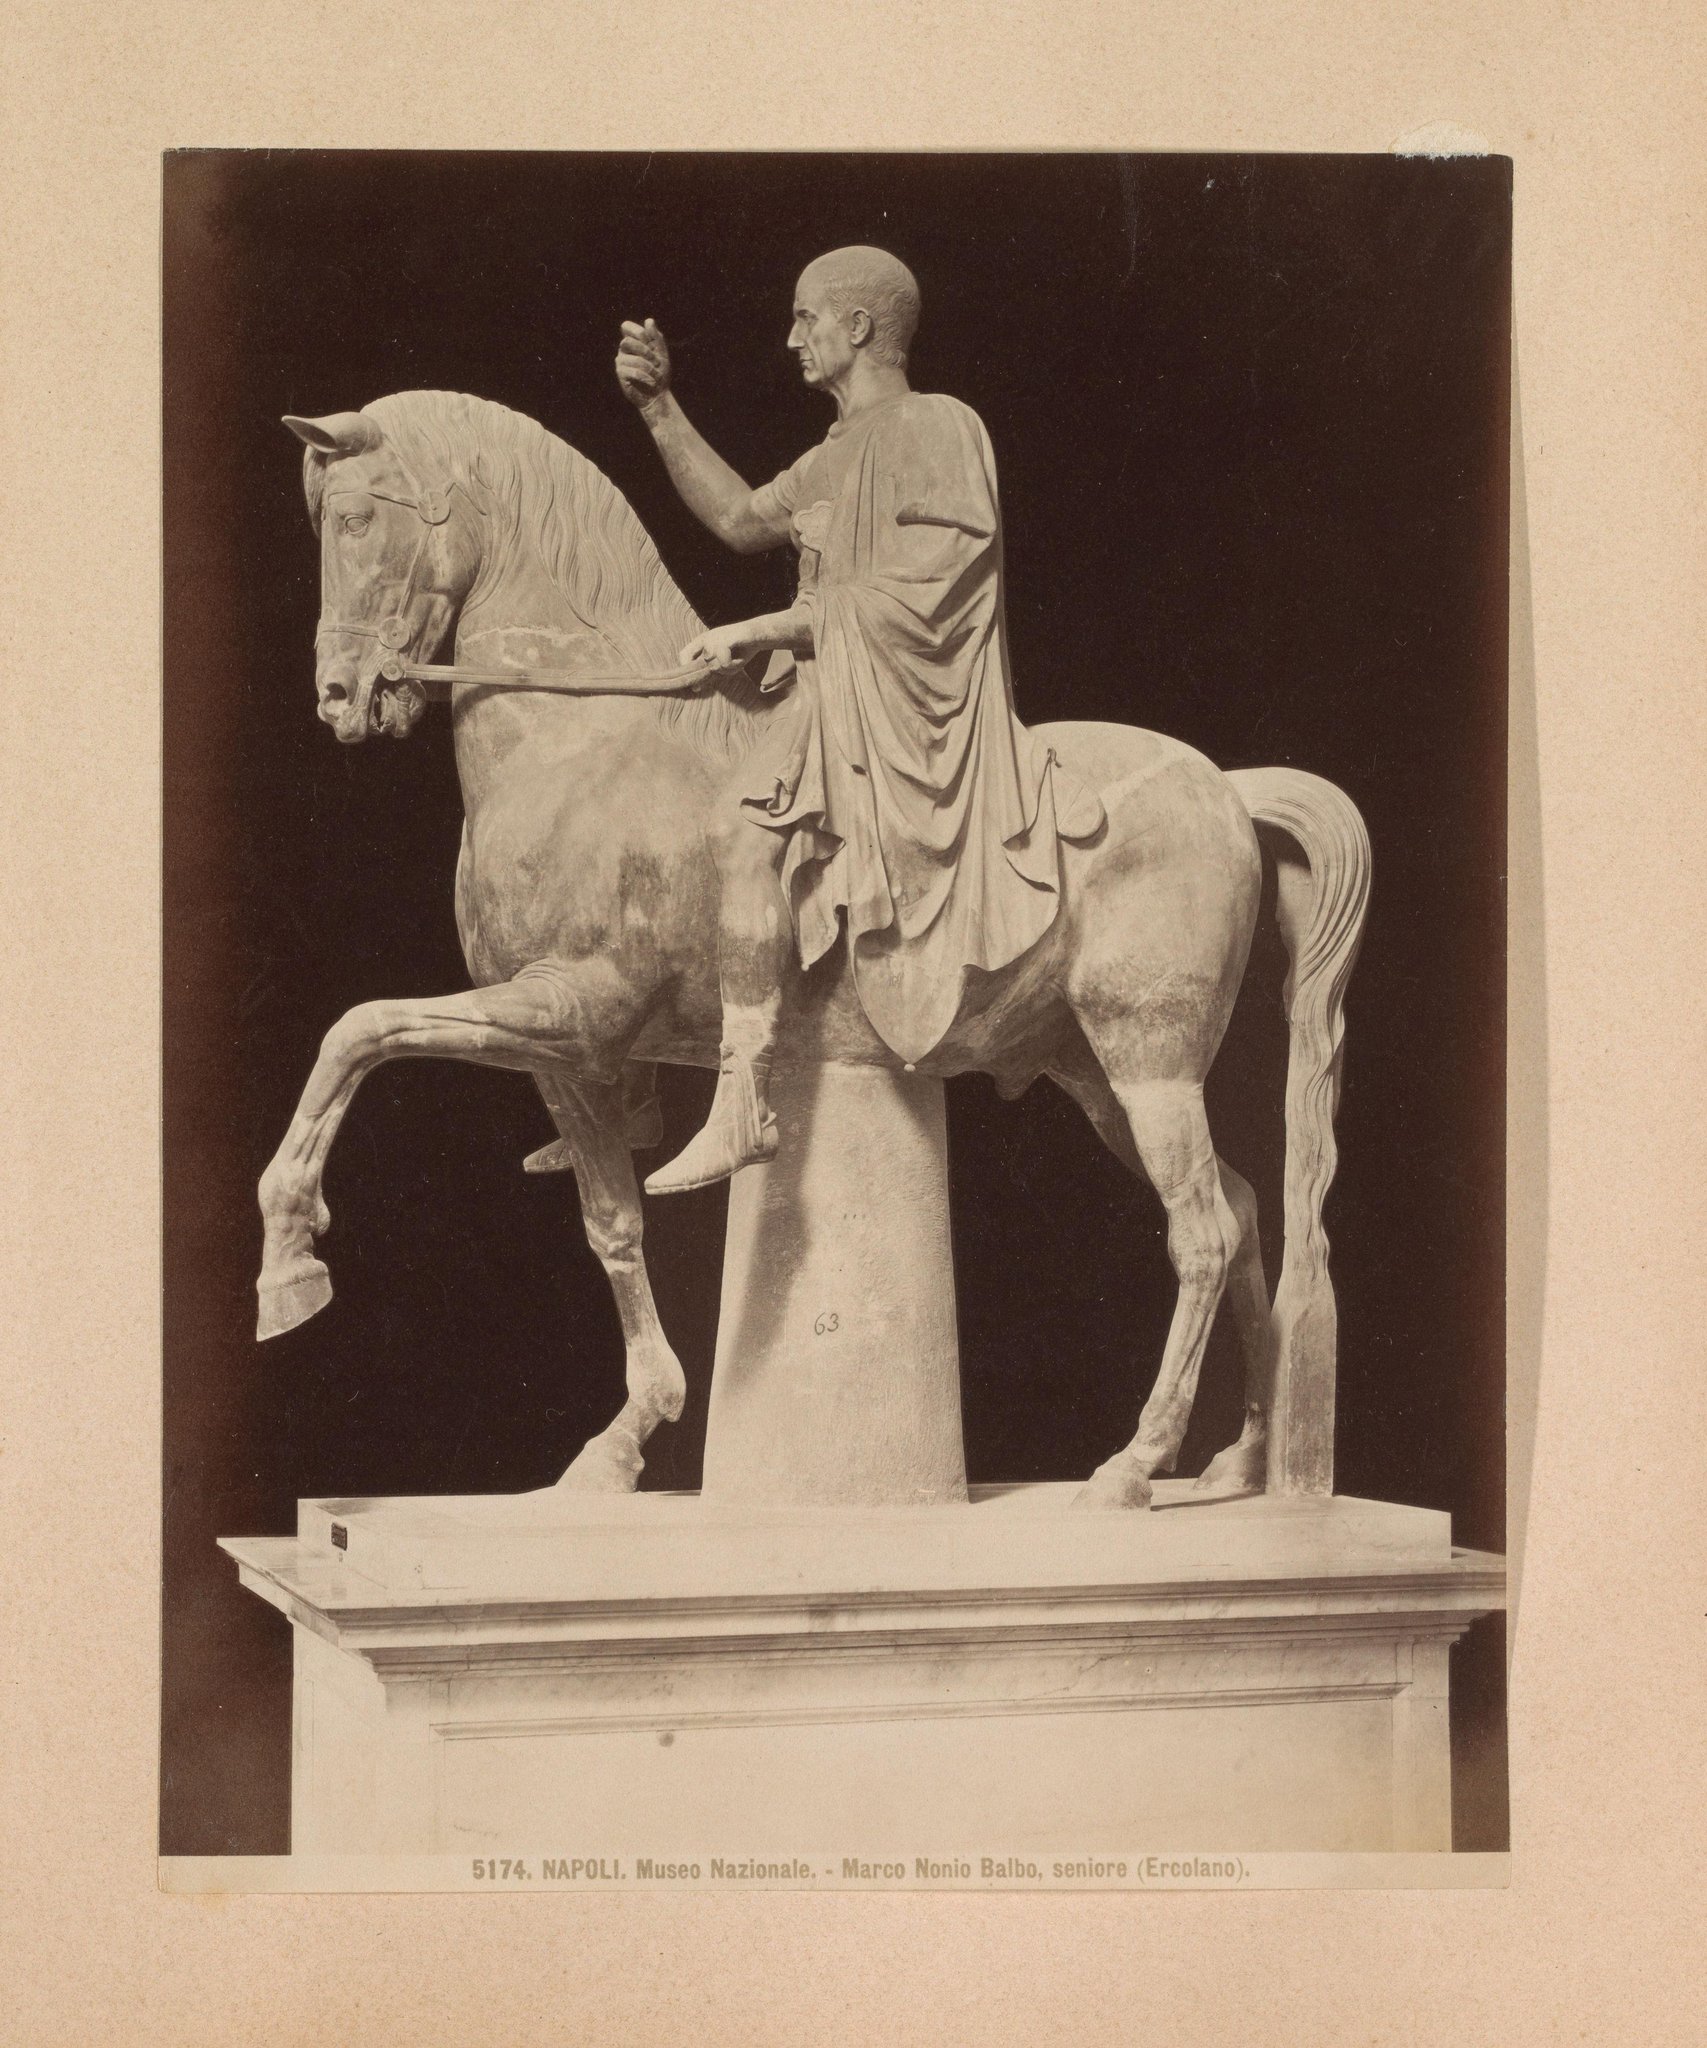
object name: photograph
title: Napoli. Museo Nazionale. - Marco Nonio Balbo, seniore (Ercolano).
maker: Anonymous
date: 1870-1900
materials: paper, photographic support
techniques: albumen print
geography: naples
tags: equestrian statue, naples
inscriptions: negative number: ‘5174’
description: Onderdeel van Reisalbum met foto's van bezienswaardigheden in Italië en Zuid-Frankrijk.